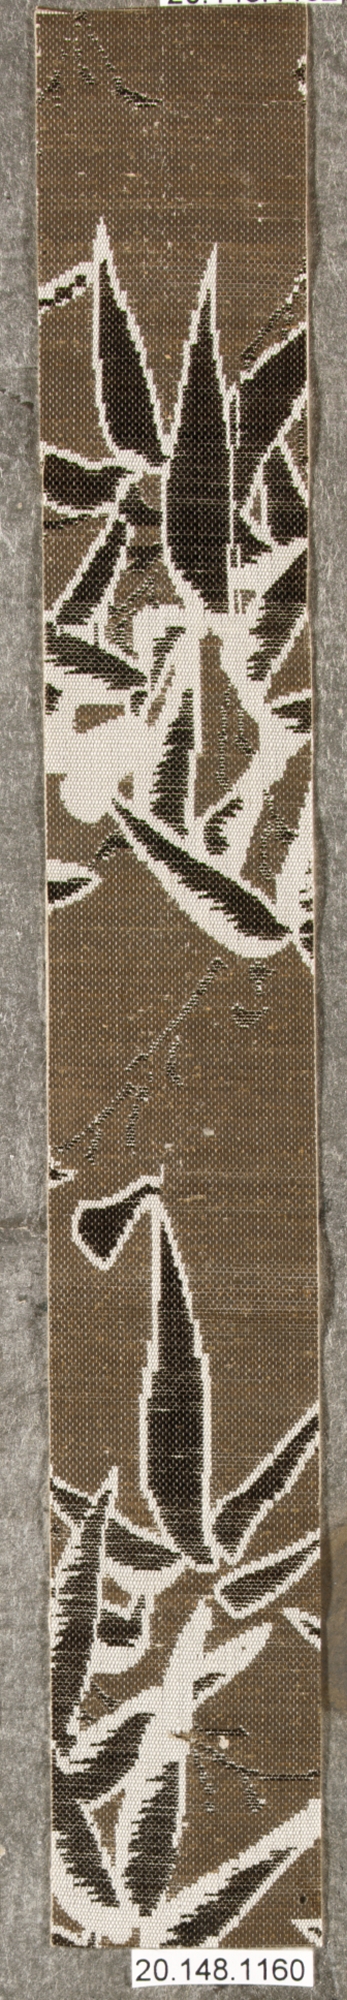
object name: piece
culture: japanese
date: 1801-1900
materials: silk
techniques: compound weave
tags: leaves